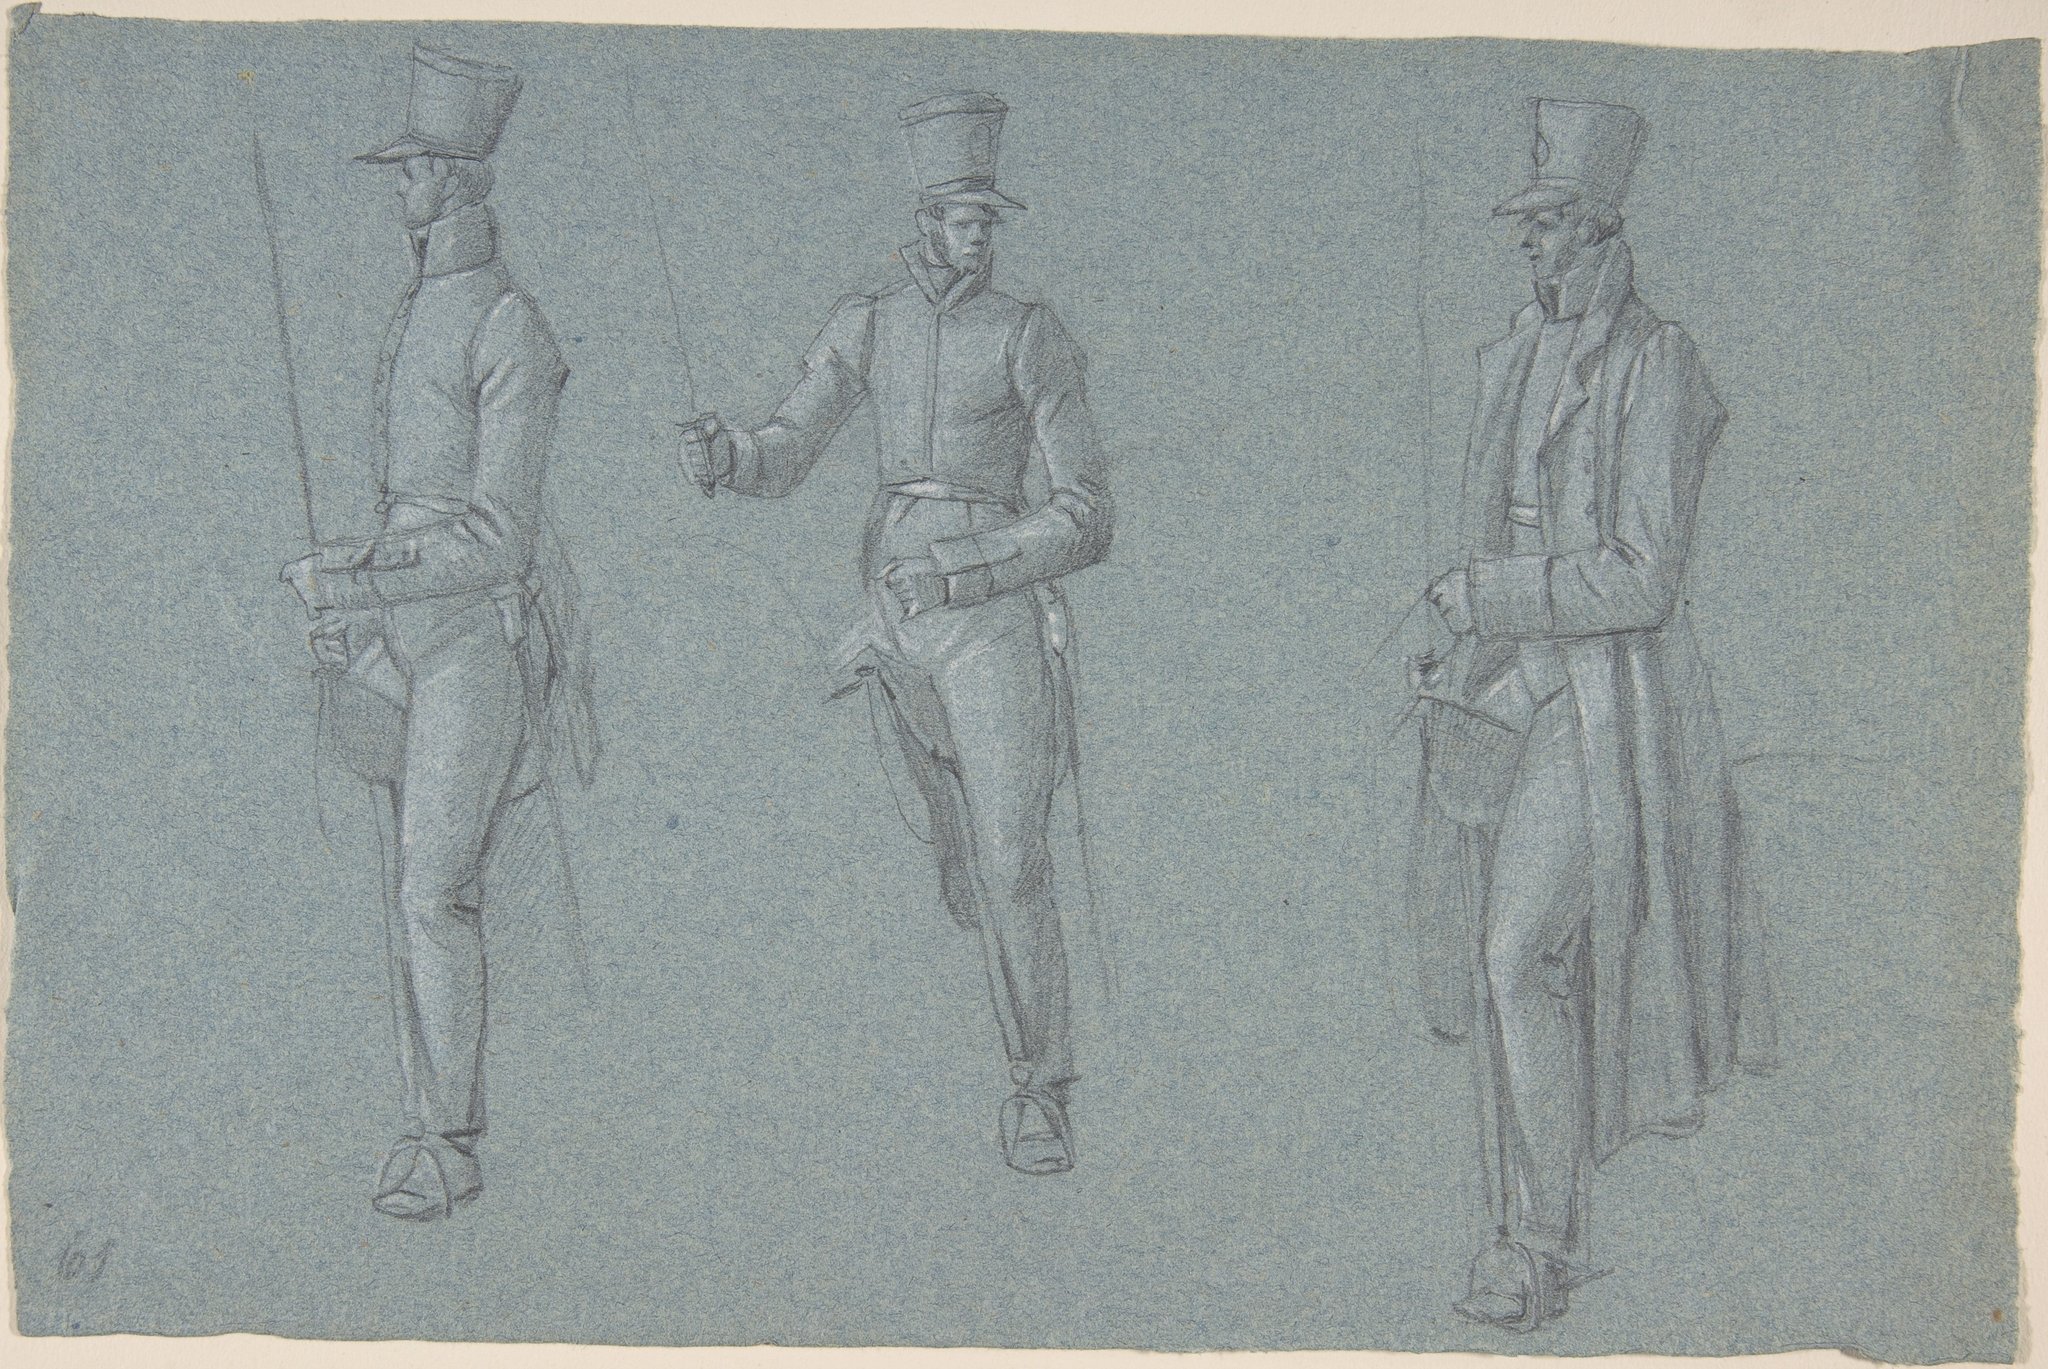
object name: drawing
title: Three studies on a man on a saddle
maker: wilhelm von kobell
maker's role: artist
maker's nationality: german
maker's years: 1766-1853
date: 1767-1833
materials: chalk, paper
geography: germany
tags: swords,men